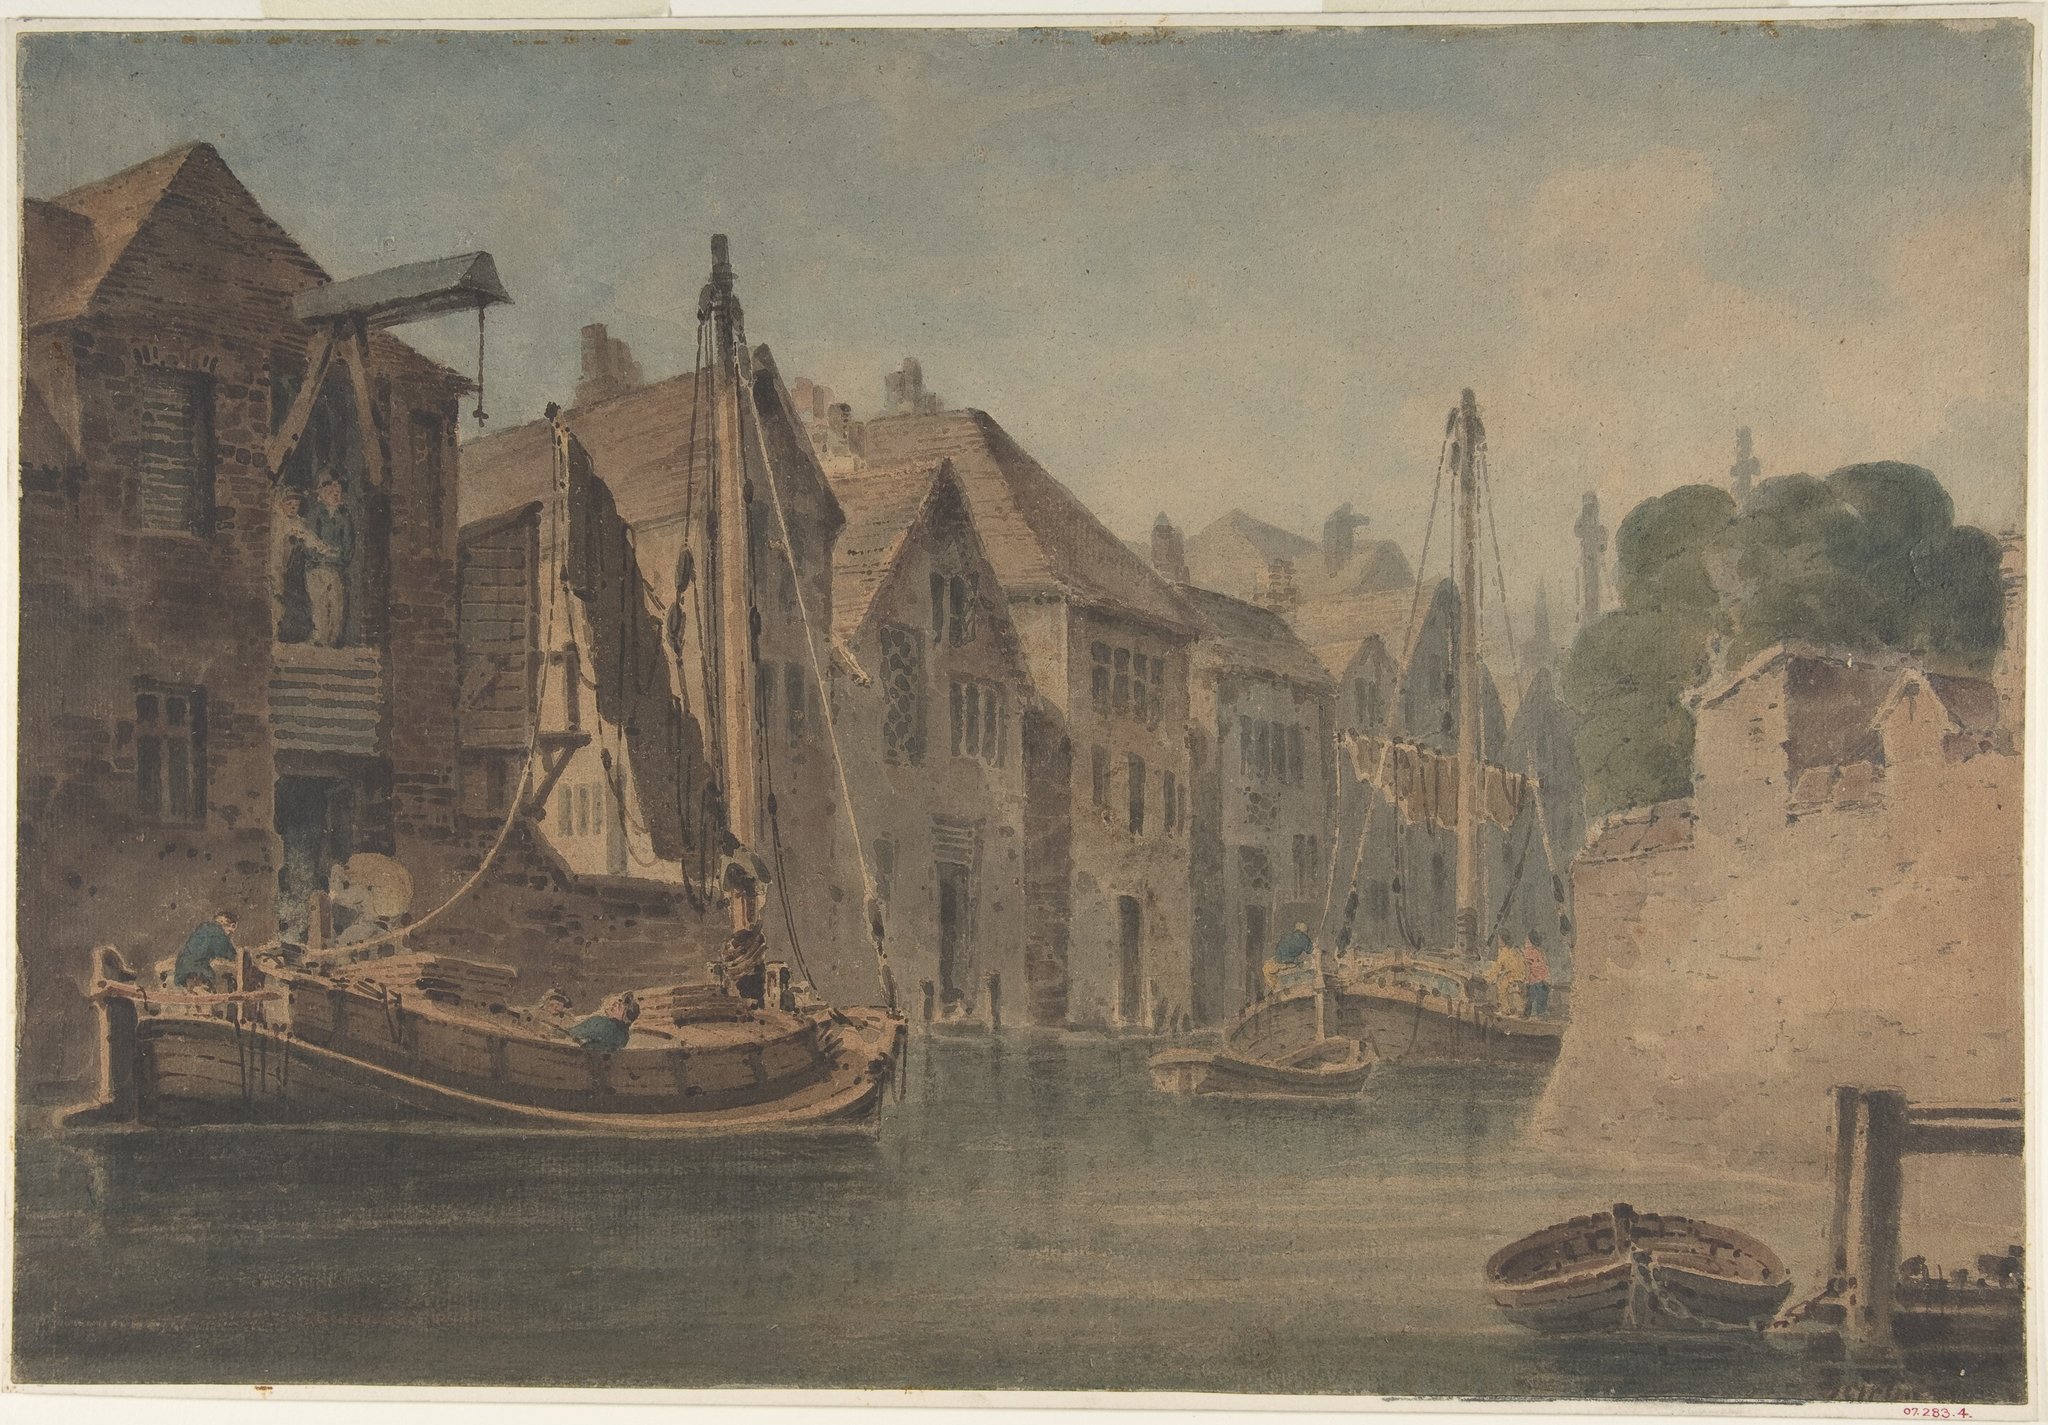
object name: drawing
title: River at Norwich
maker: thomas girtin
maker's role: artist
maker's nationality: british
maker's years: 1775-1802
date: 1801-1833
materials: watercolor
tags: houses,rivers,trees,boats